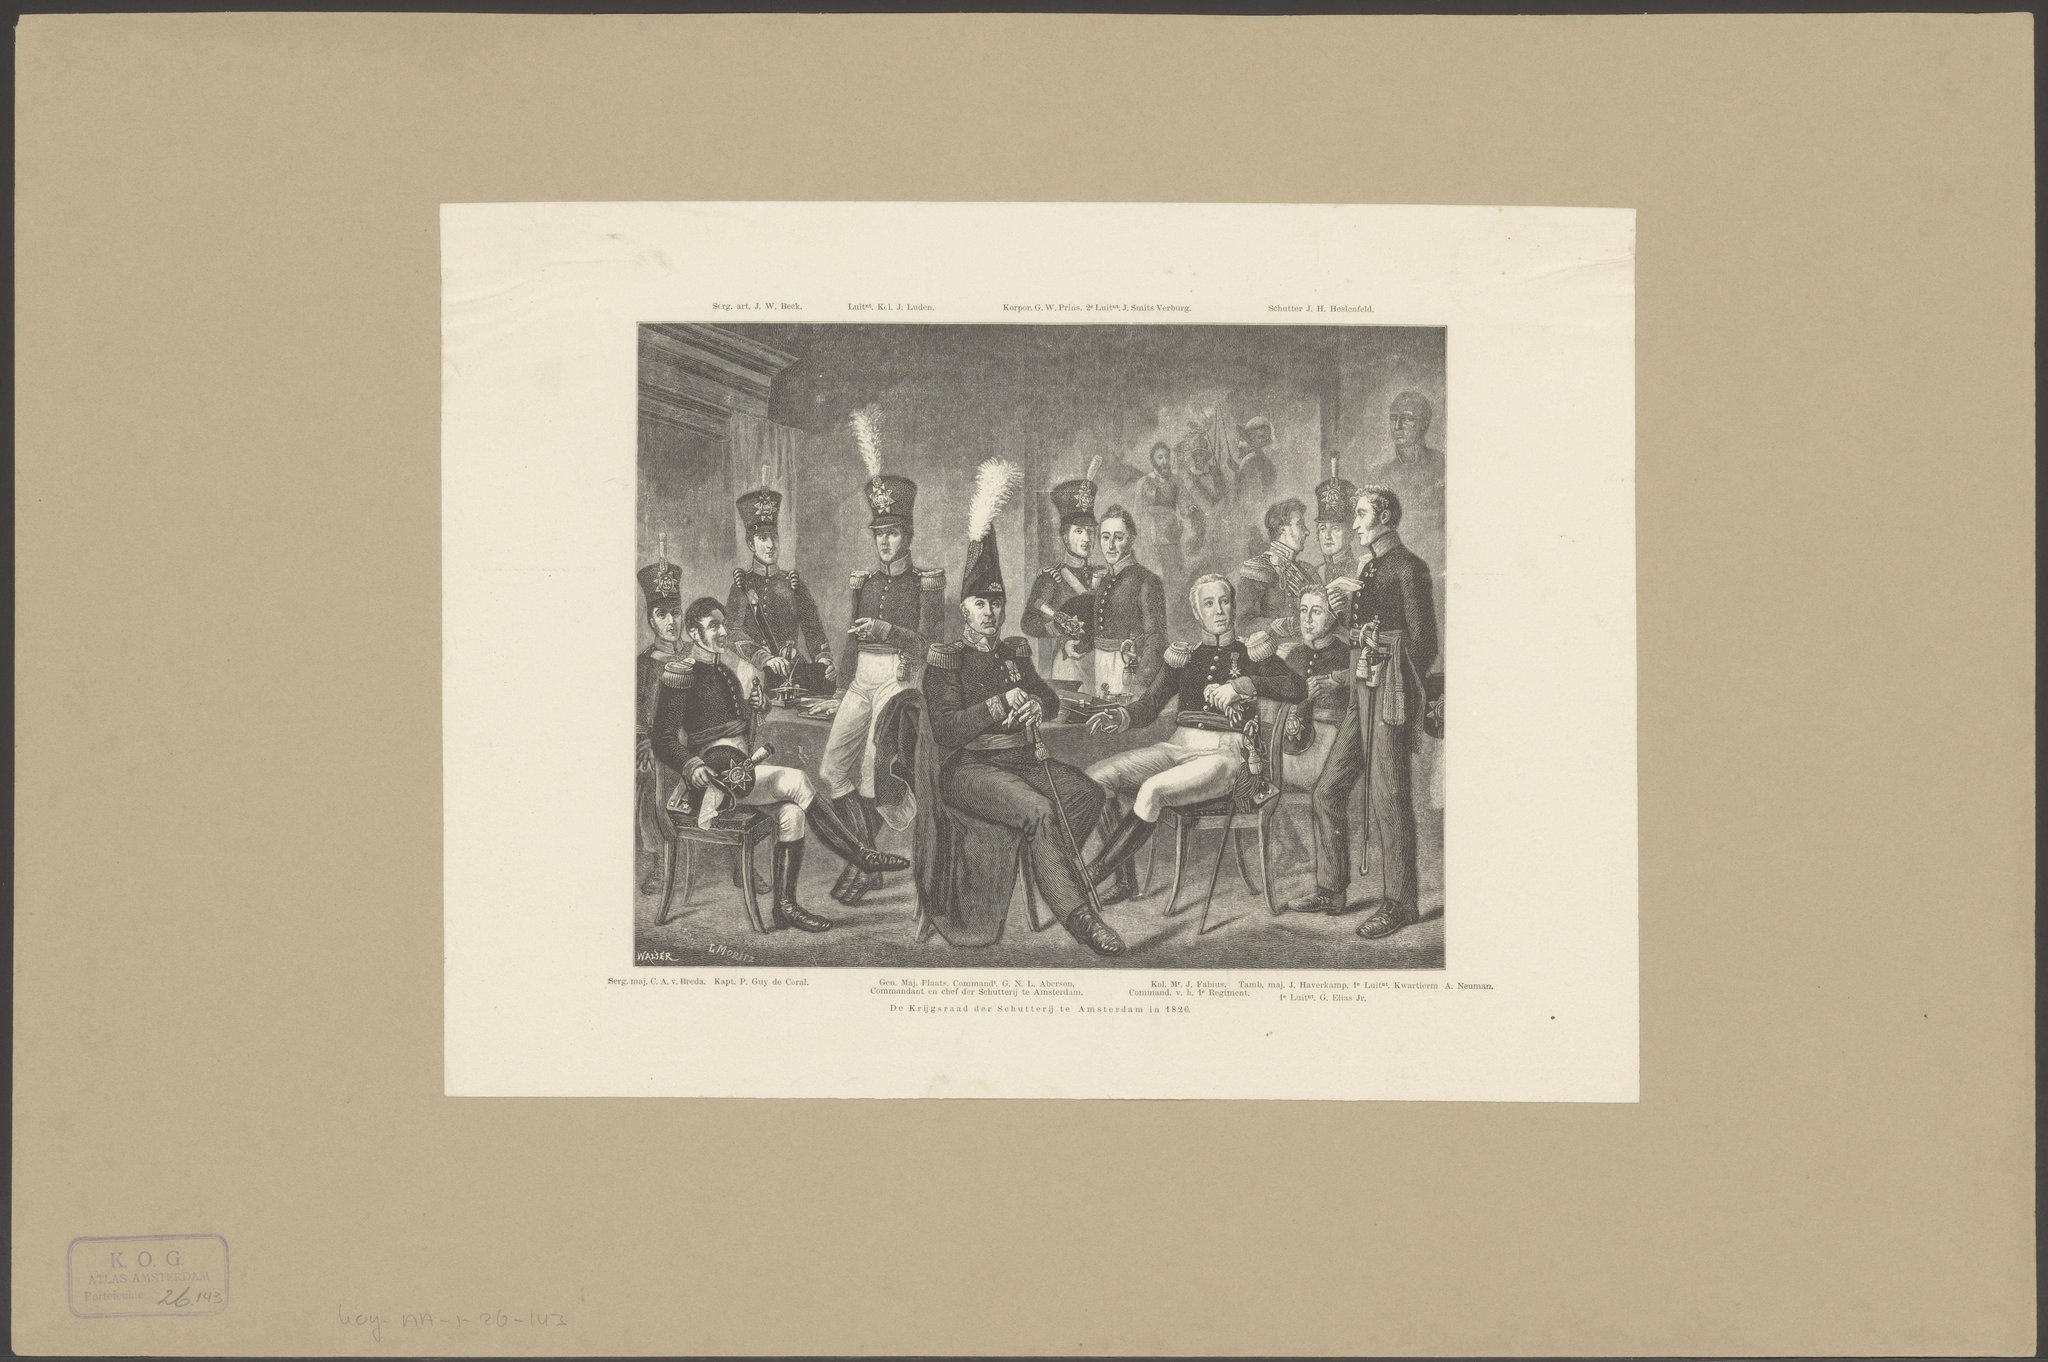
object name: print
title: De Krijgsraad der Schutterij te Amsterdam in 1826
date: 1889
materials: paper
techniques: letterpress printing, engraving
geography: netherlands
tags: politician, historical persons, military service (+ citizen soldiery, civil guard, citizen militia), amsterdam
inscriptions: collector's mark: Lugt 1641b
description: Dezelfde staat en typografie gebruikt in: Eigen Haard 15 (1889), nr. 1, 5 januari 1889, p. 7.